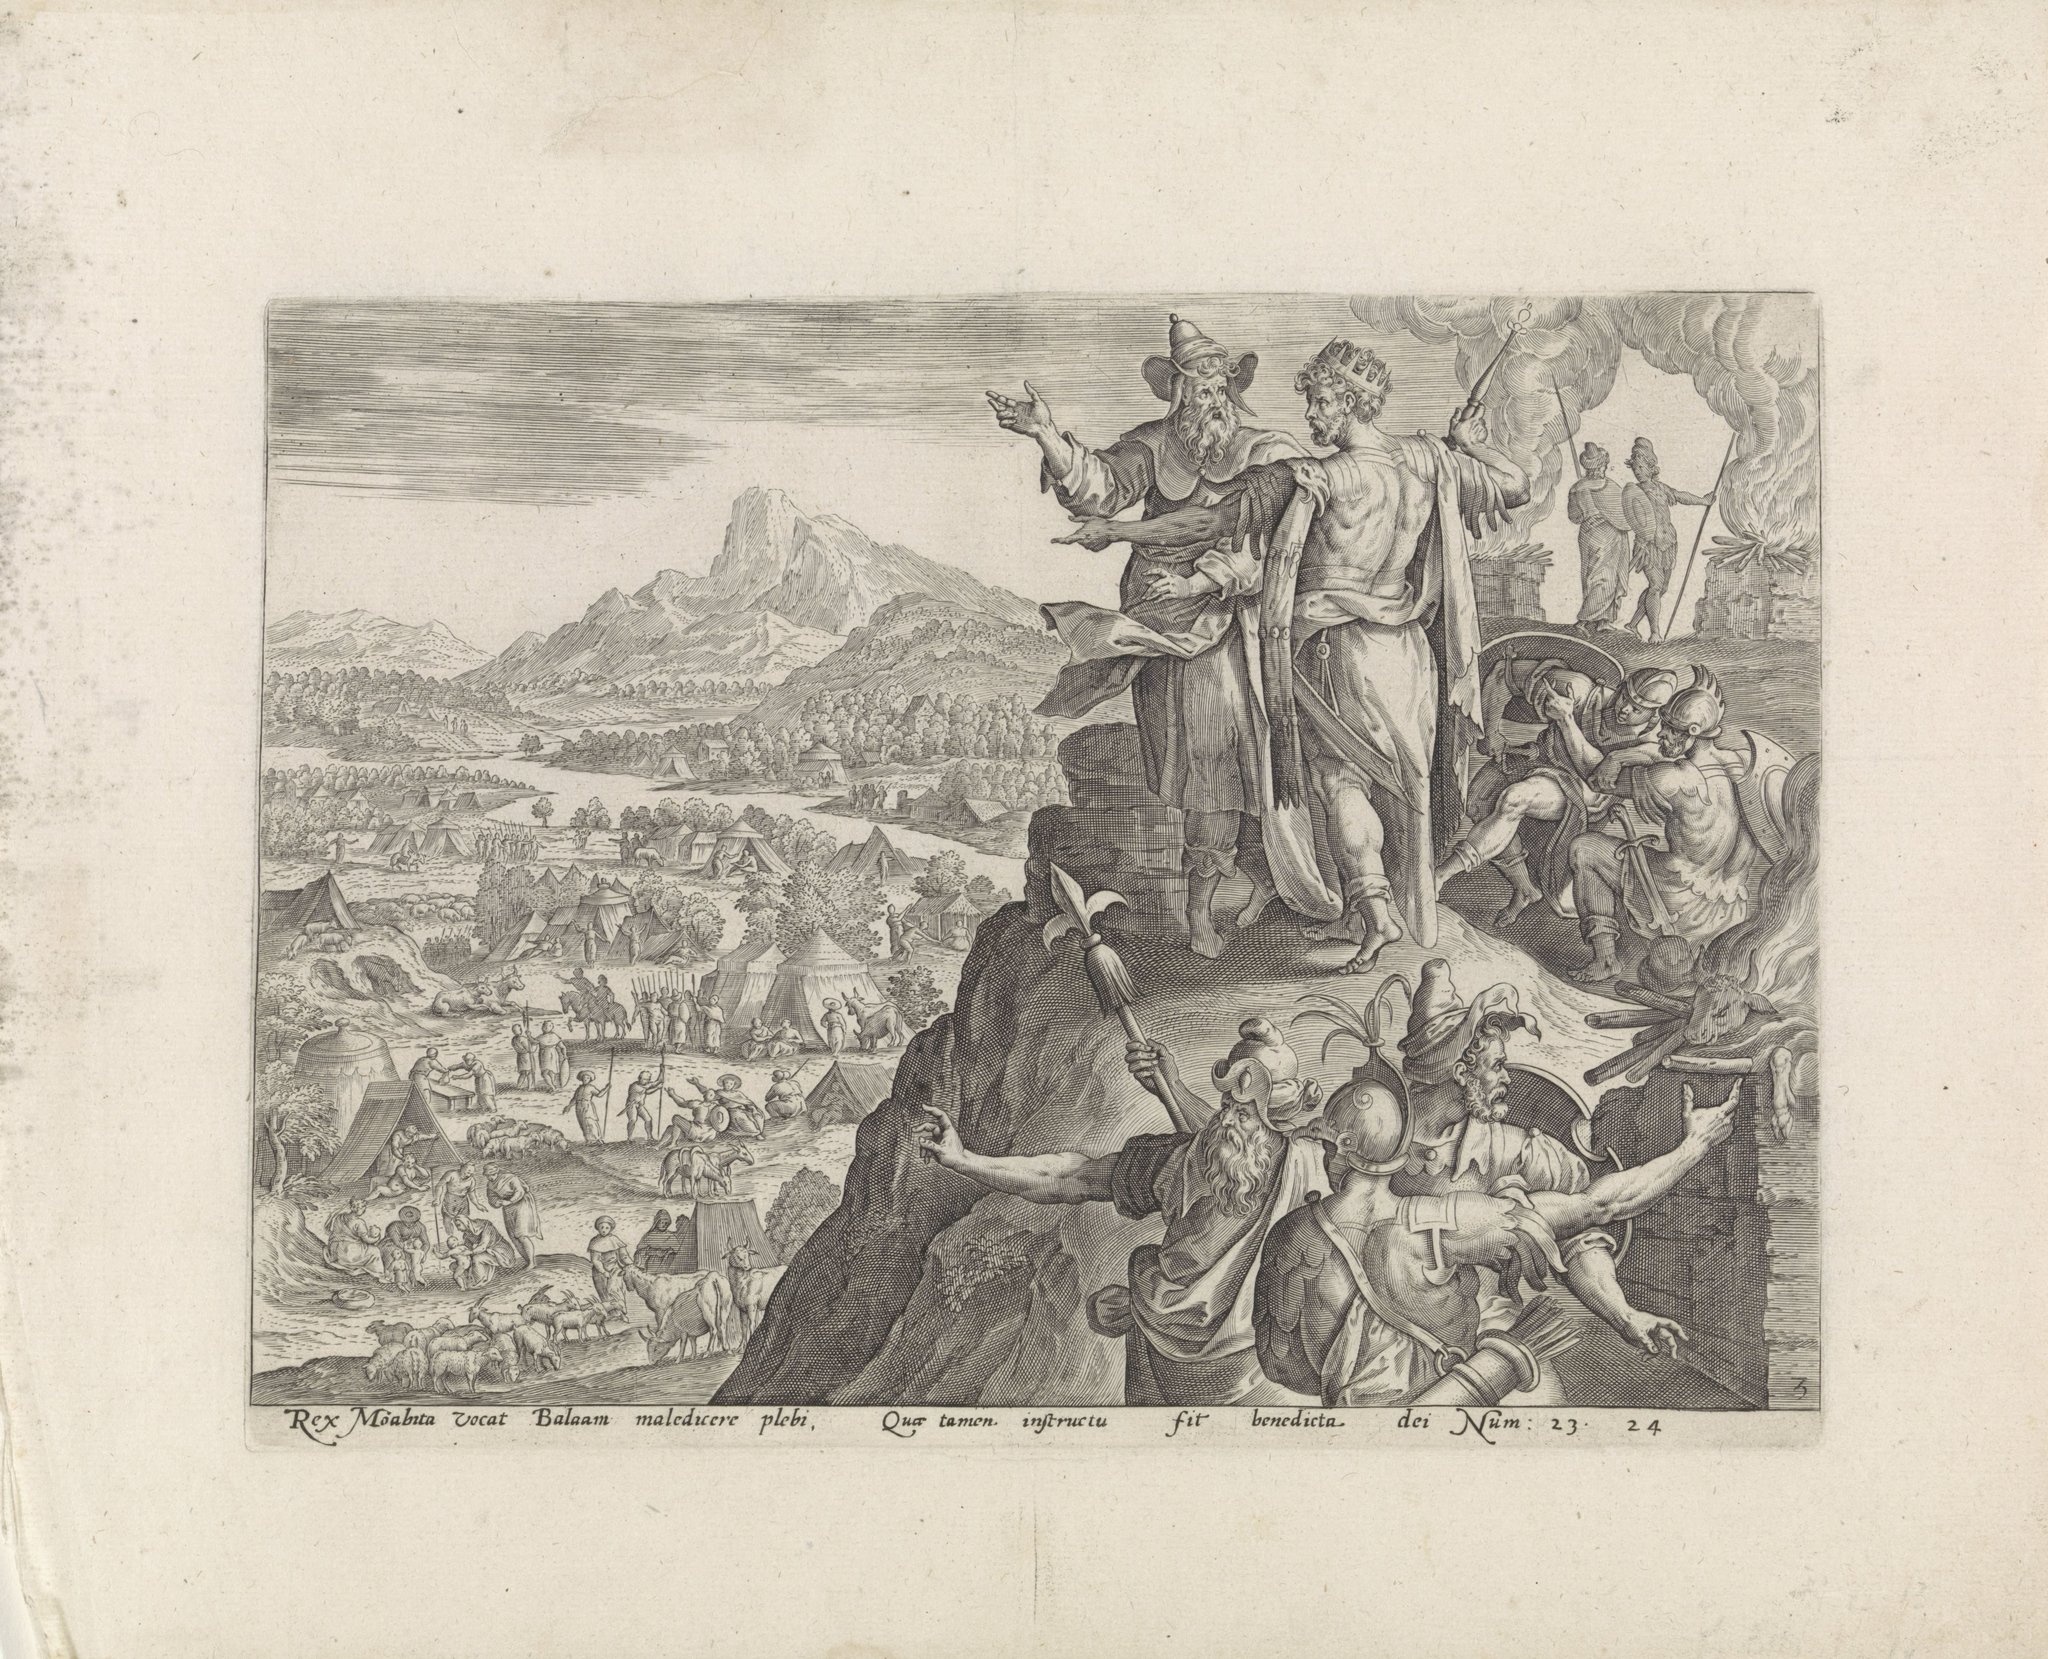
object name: print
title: Bileam en koning Balak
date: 1585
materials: paper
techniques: engraving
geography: antwerp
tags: balaam is taken up to the high places of baal and sees the israelite camp, balaam prophesying and blessing the israelites in the presence of king balak and his chieftains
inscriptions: collector's mark: Lugt 2228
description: Bileam staat met Balak, de koning van Moab, op een berg en zij kijken uit over het tentenkamp van de Israëlieten. Balak wil dat Bileam het volk vervloekt, maar Bileam zegent ze juist. Op de berg zijn altaren opgericht en er staan Moabitische strijders. Onder de voorstelling een verwijzing in het Latijn naar de Bijbeltekst in Num. 23-24.